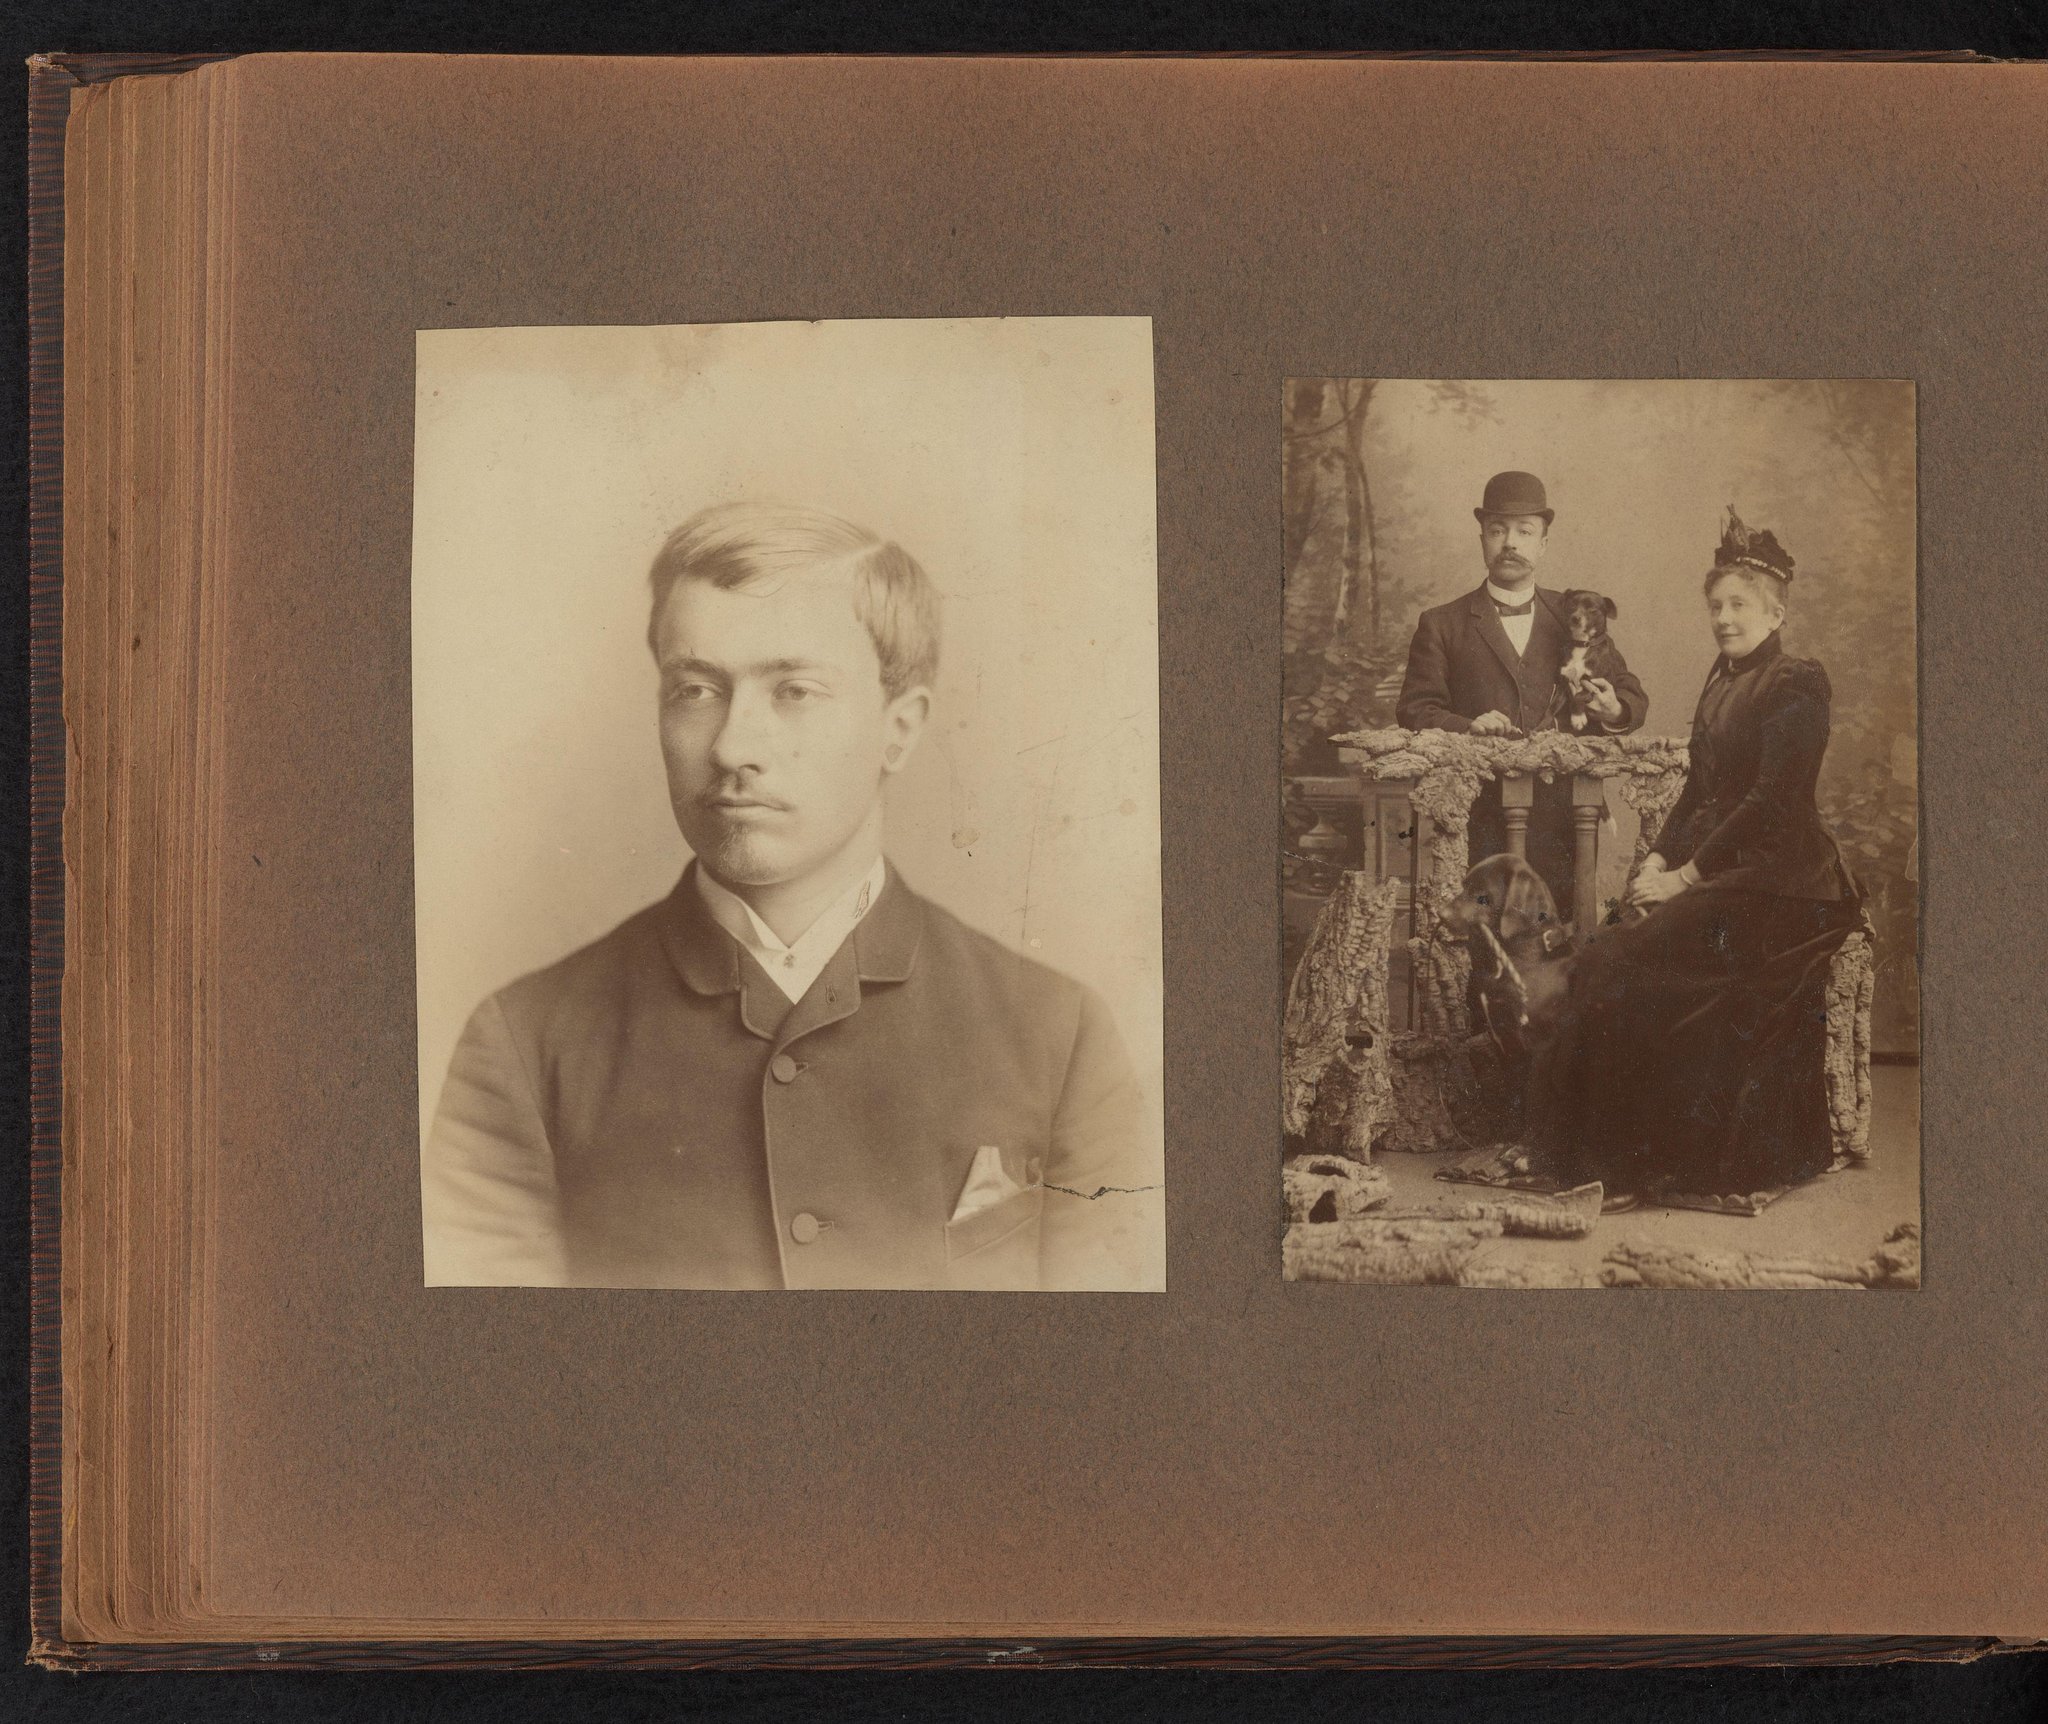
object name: album leaf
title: Bladzijde uit het fotoalbum van de familie Diepenbrock met 2 foto's van Alphons Diepenbrock en zijn omgeving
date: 1870-1920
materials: cardboard, photographic support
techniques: photography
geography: amsterdam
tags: netherlands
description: Bruin albumblad 32 van familiealbum van Alphons Diepenbrock.